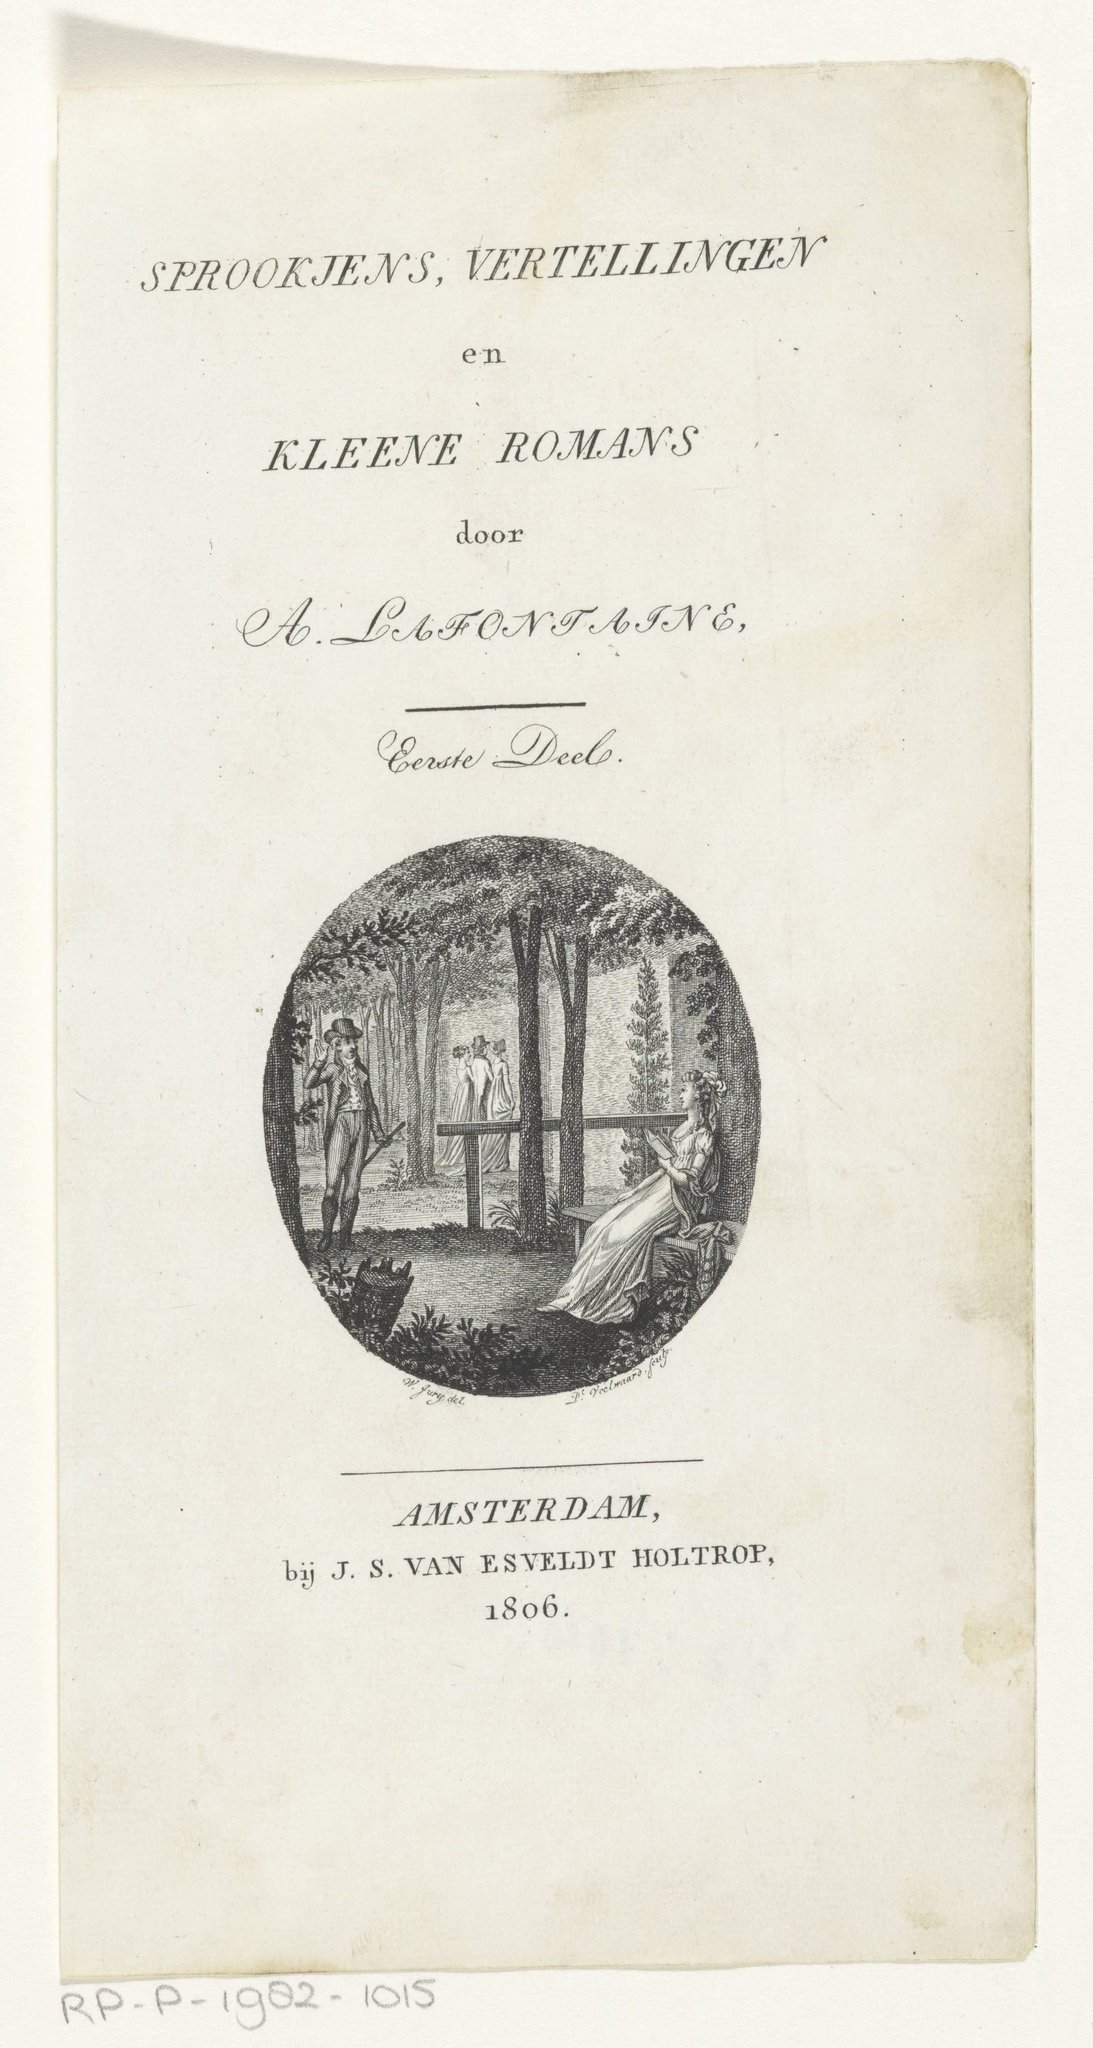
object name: print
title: Titelpagina voor: A. Lafontaine, Sprookjens, vertellingen en kleene romans, 1806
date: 1806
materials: paper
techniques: engraving, etching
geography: amsterdam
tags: reading, garden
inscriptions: collector's mark: Lugt 2760, collector's mark: Lugt 2228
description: Een lezende vrouw in een tuin wordt begroet door een man met hoed en stok links. In de achtergrond loopt een man met twee vrouwen aan zijn arm.